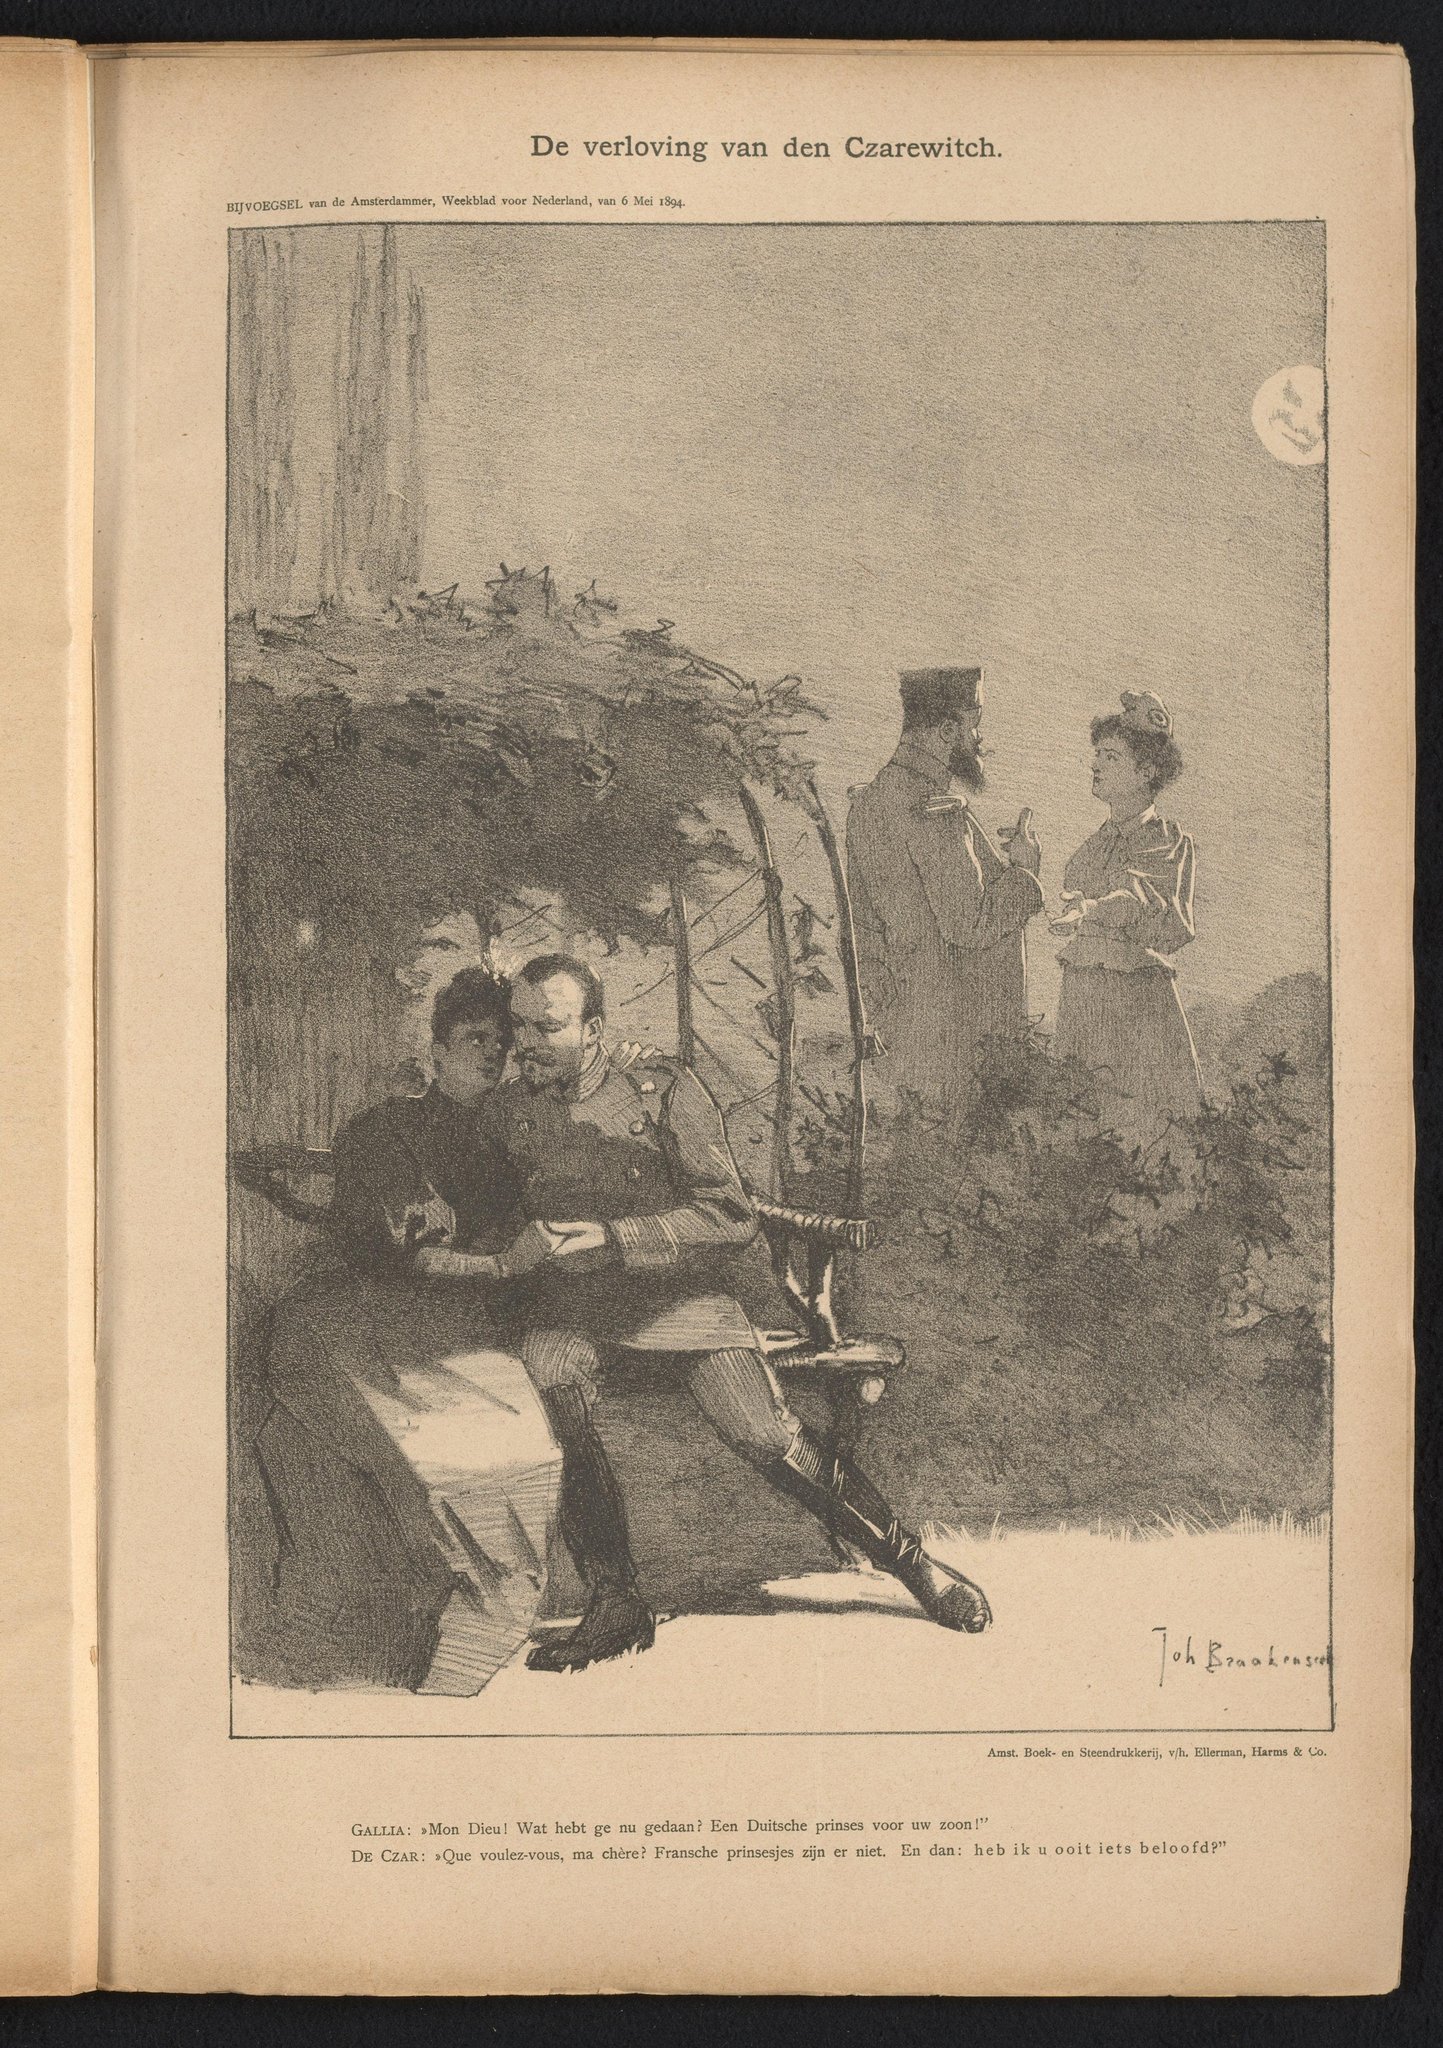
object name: cartoon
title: De verloving van den Czarewitch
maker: johan braakensiek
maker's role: draughtsman, print maker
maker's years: 1858-1940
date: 1894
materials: paper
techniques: lithograph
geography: amsterdam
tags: personifications of countries, nations, states, districts, etc., betrothal, political caricatures and satires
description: Marianne (Frankrijk) laat tsaar Alexander III weten dat hij een Duitse prinses, Alix van Hessen-Darmstadt, heeft gekozen als verloofde voor de tsarevitsj Nicolaas. Avondscène in de tuin.